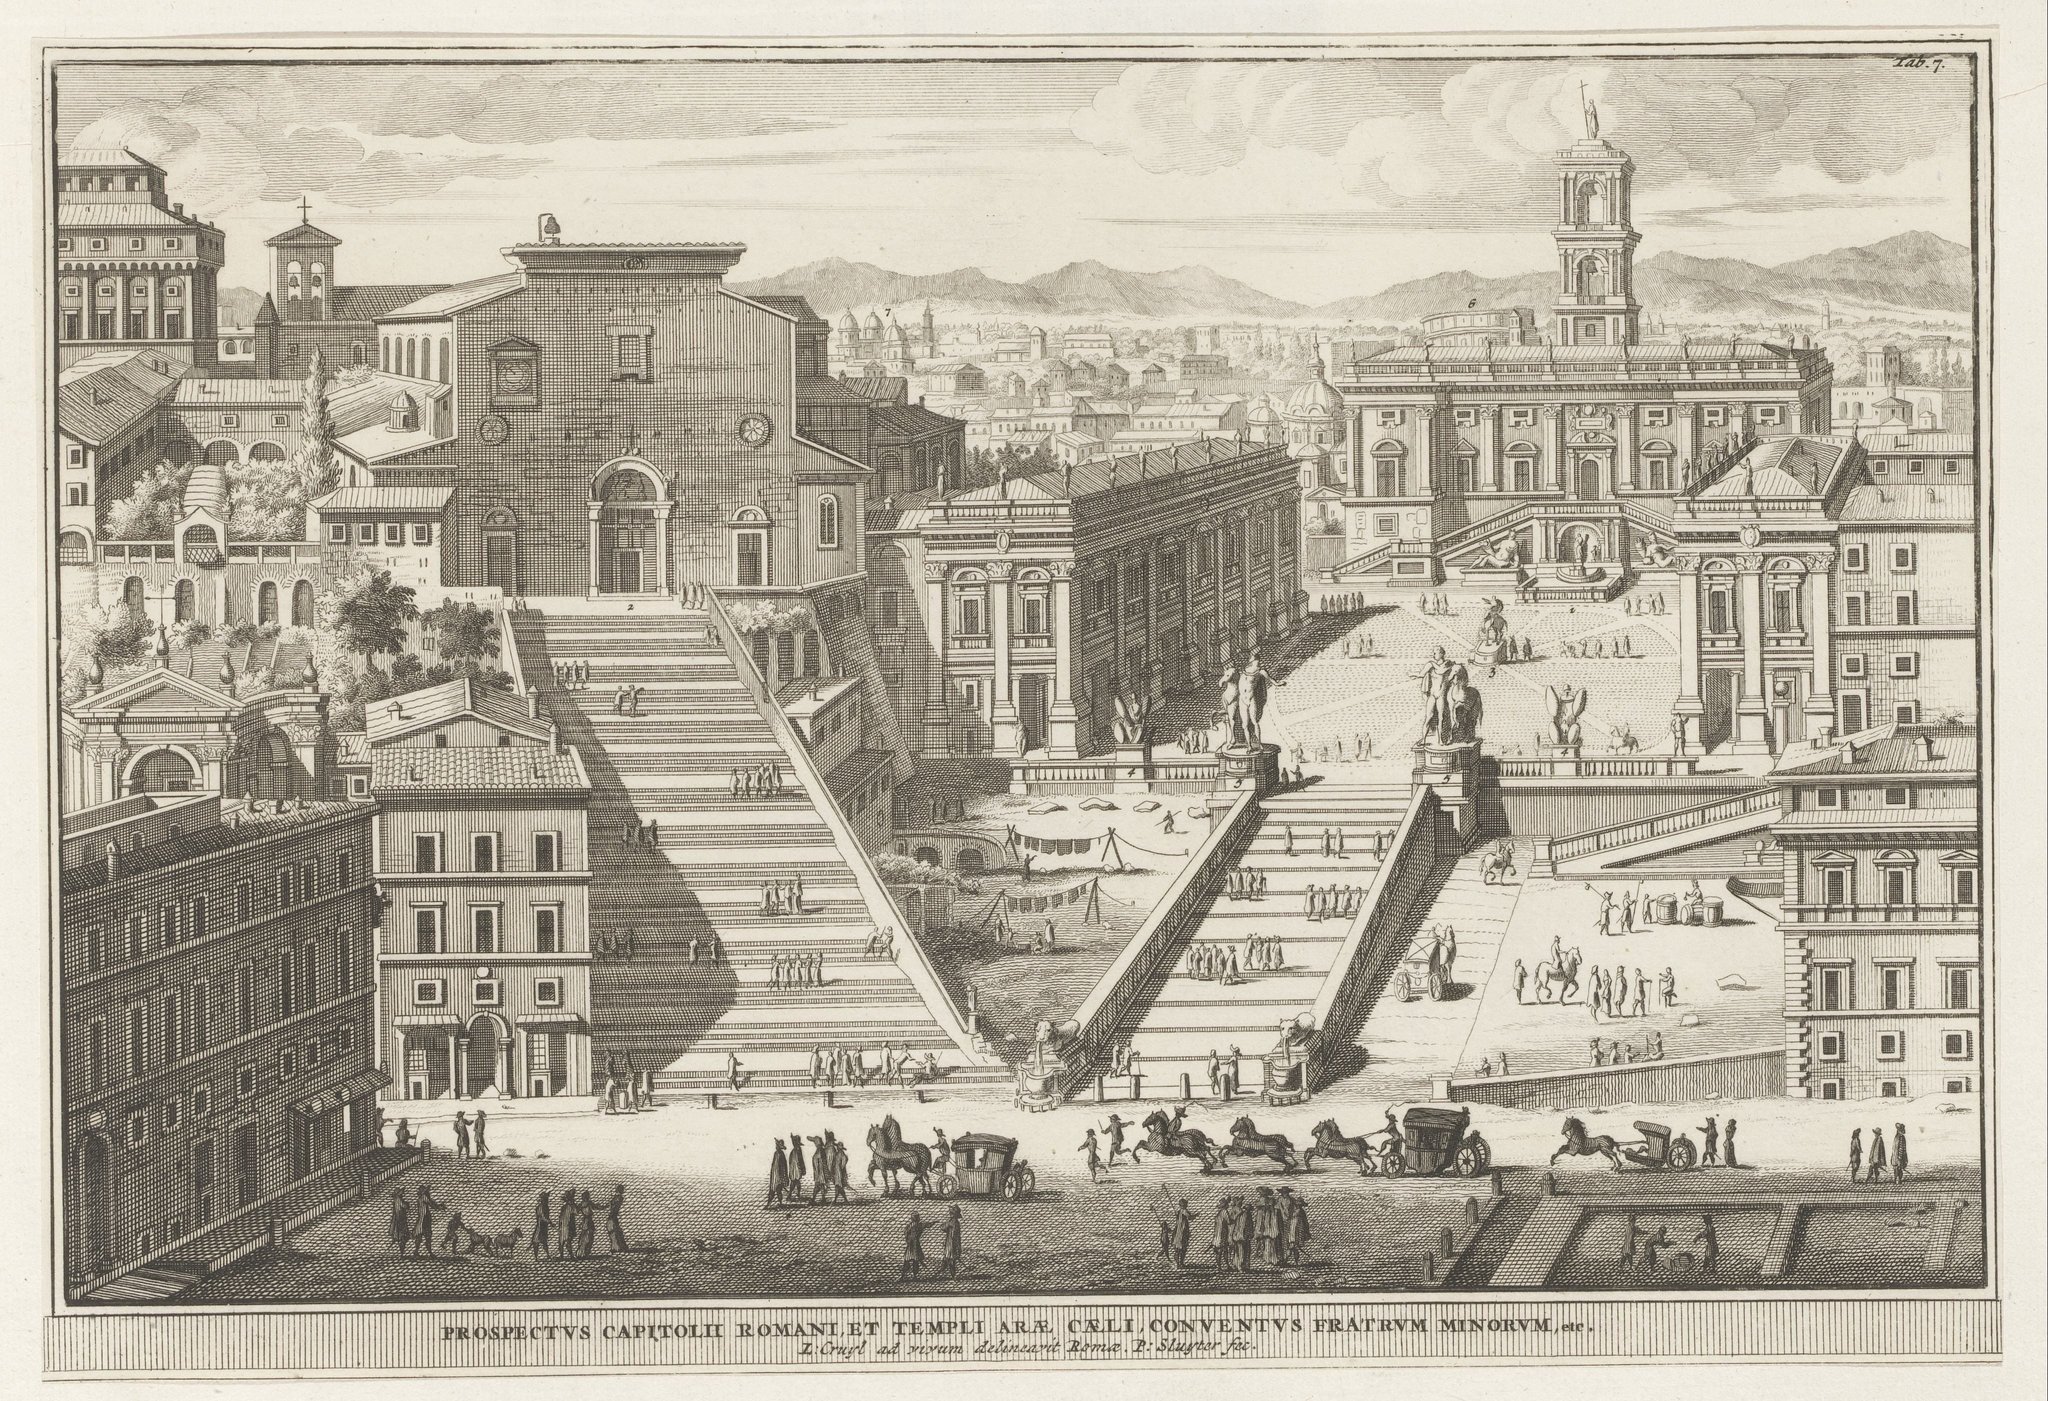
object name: album leaf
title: Magesyn der Italiaense gebouwen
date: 1729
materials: paper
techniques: etching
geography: leiden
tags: city-view, and landscape with man-made constructions, church (exterior), roman catholic church, street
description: Gezicht op de trappen leidend naar de Santa Maria in Aracoeli en het Piazza del Campidoglio op de Capitoolheuvel te Rome. Genummerd rechtsboven: Tab. 7. De prent maakt deel uit van een album.